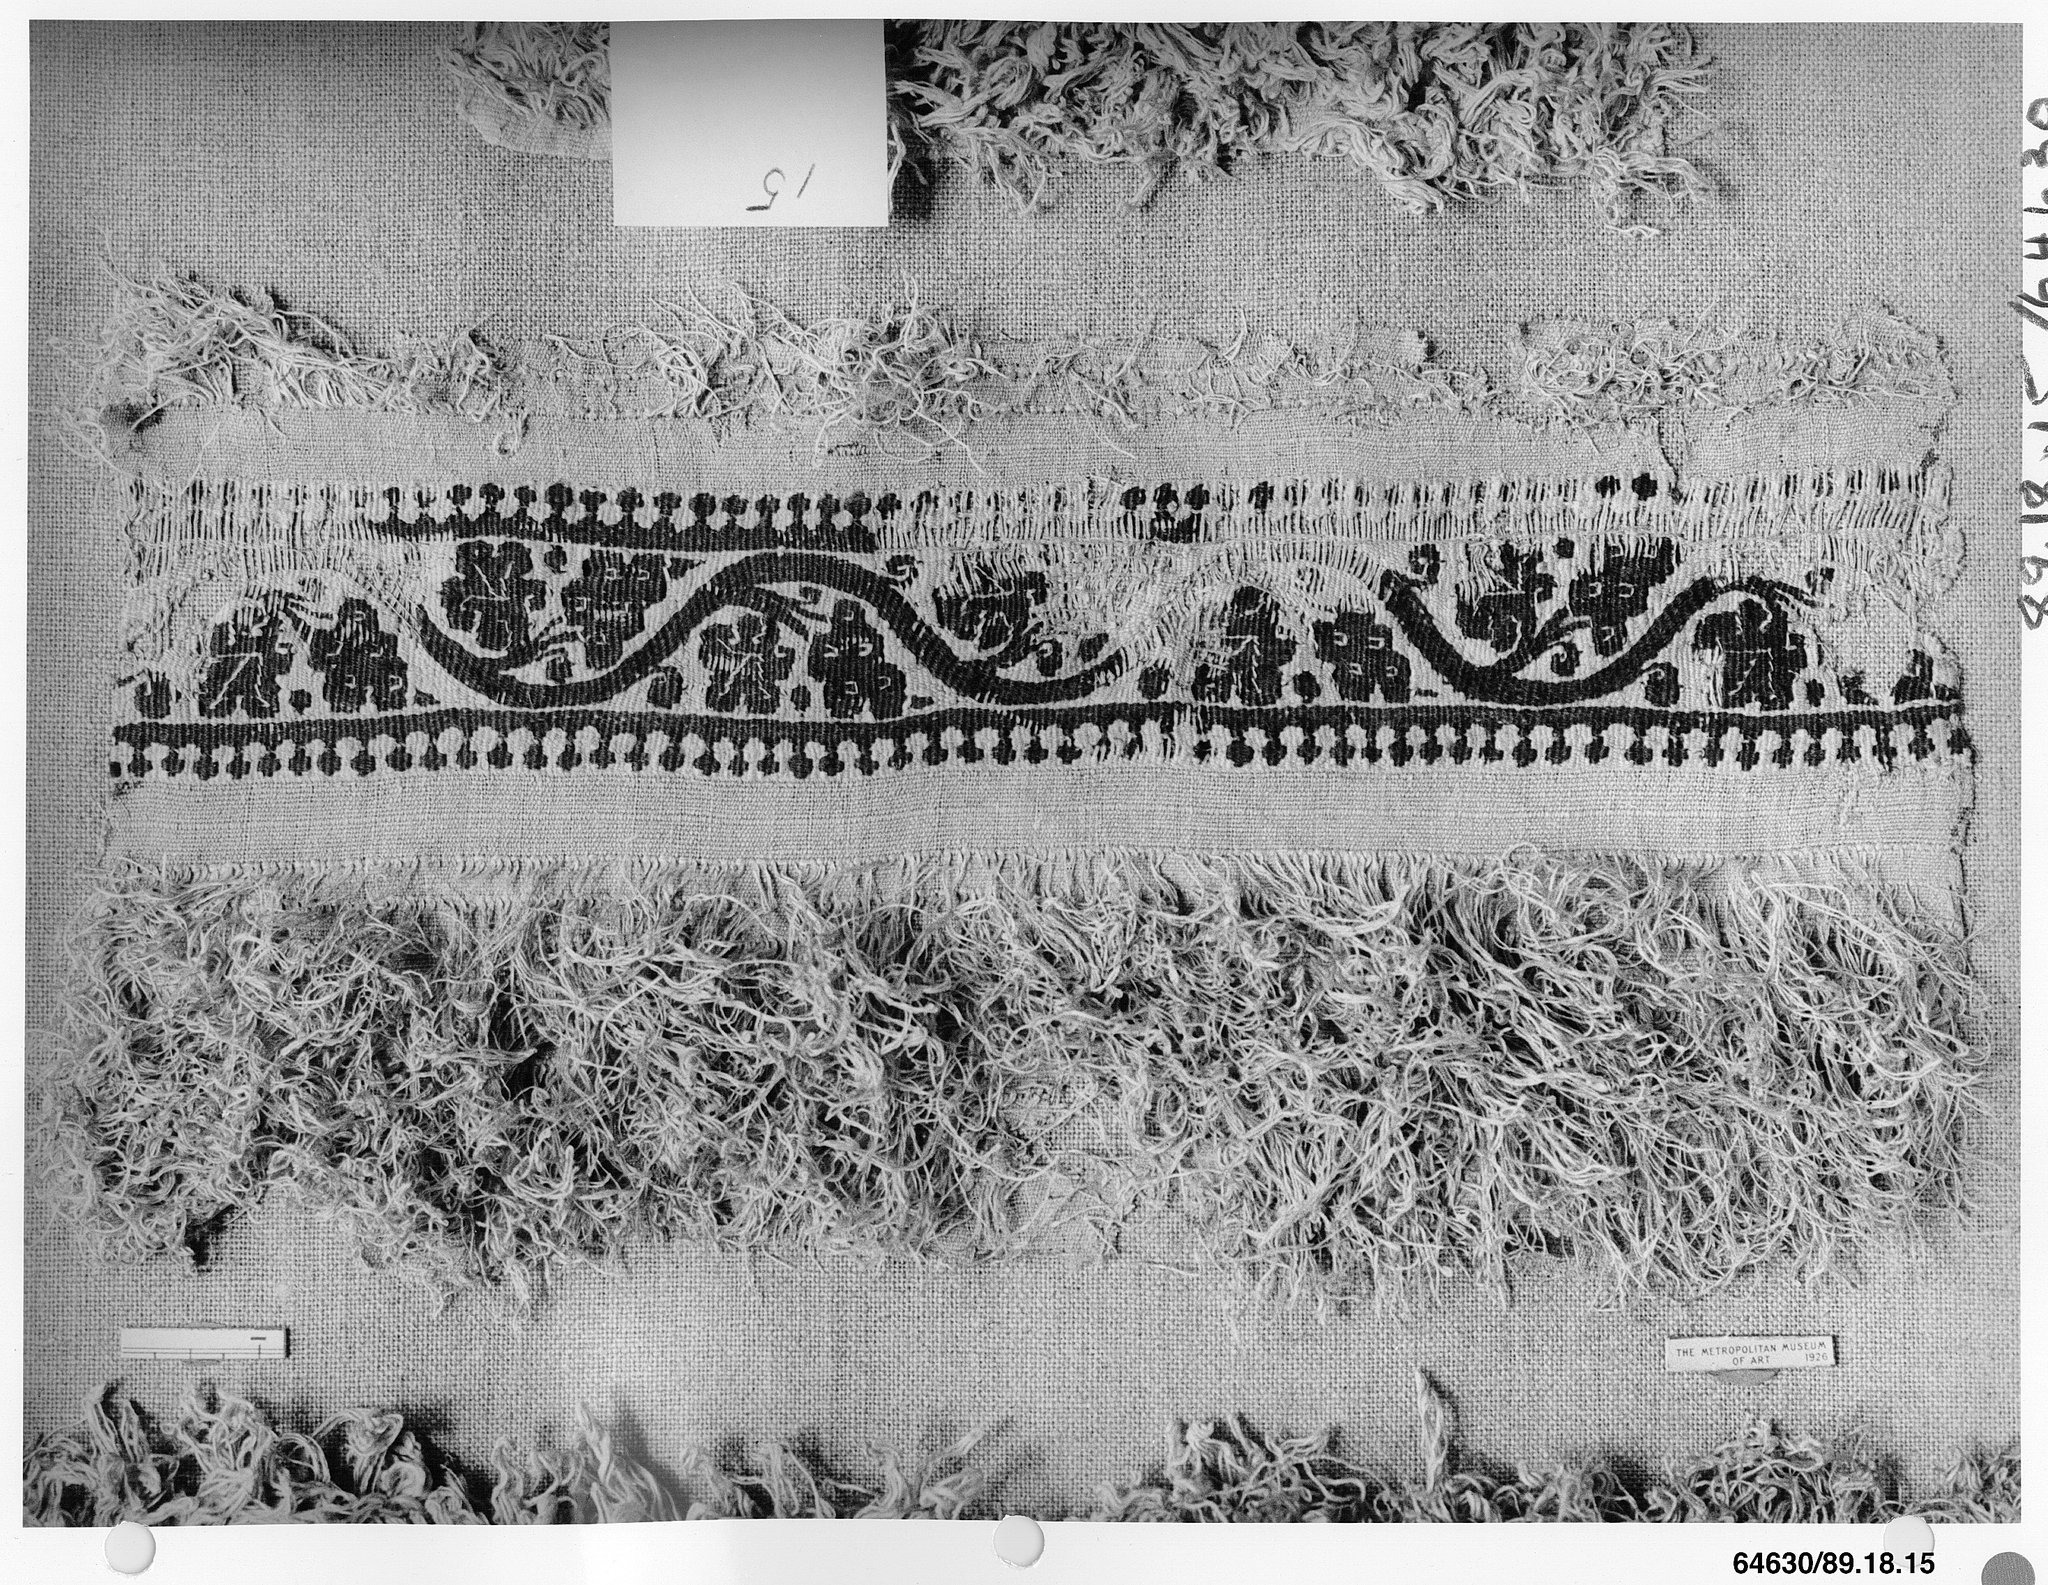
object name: textile fragment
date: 201-400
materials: linen, wool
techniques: weave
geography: egypt